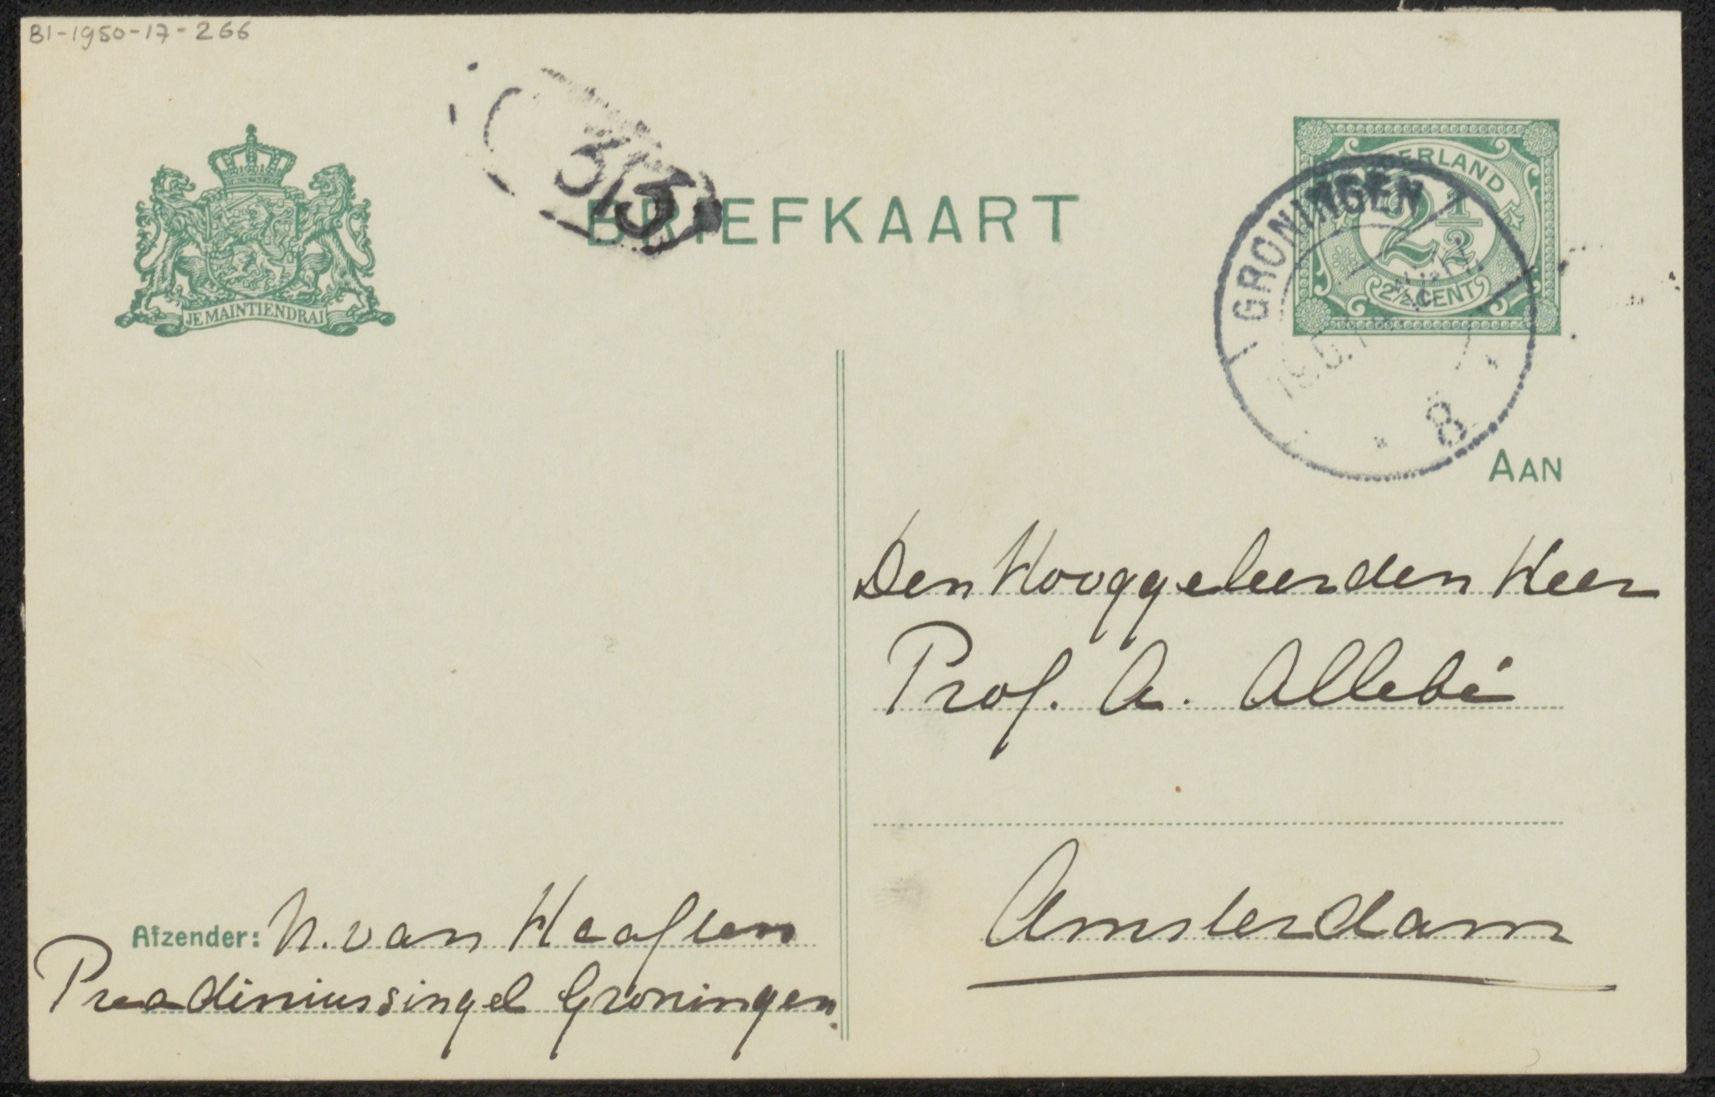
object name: postcard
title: Briefkaart aan August Allebé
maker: nettie van haaften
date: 1914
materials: cardboard, ink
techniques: pen, writing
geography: groningen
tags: print maker, draughtsman, august allebé